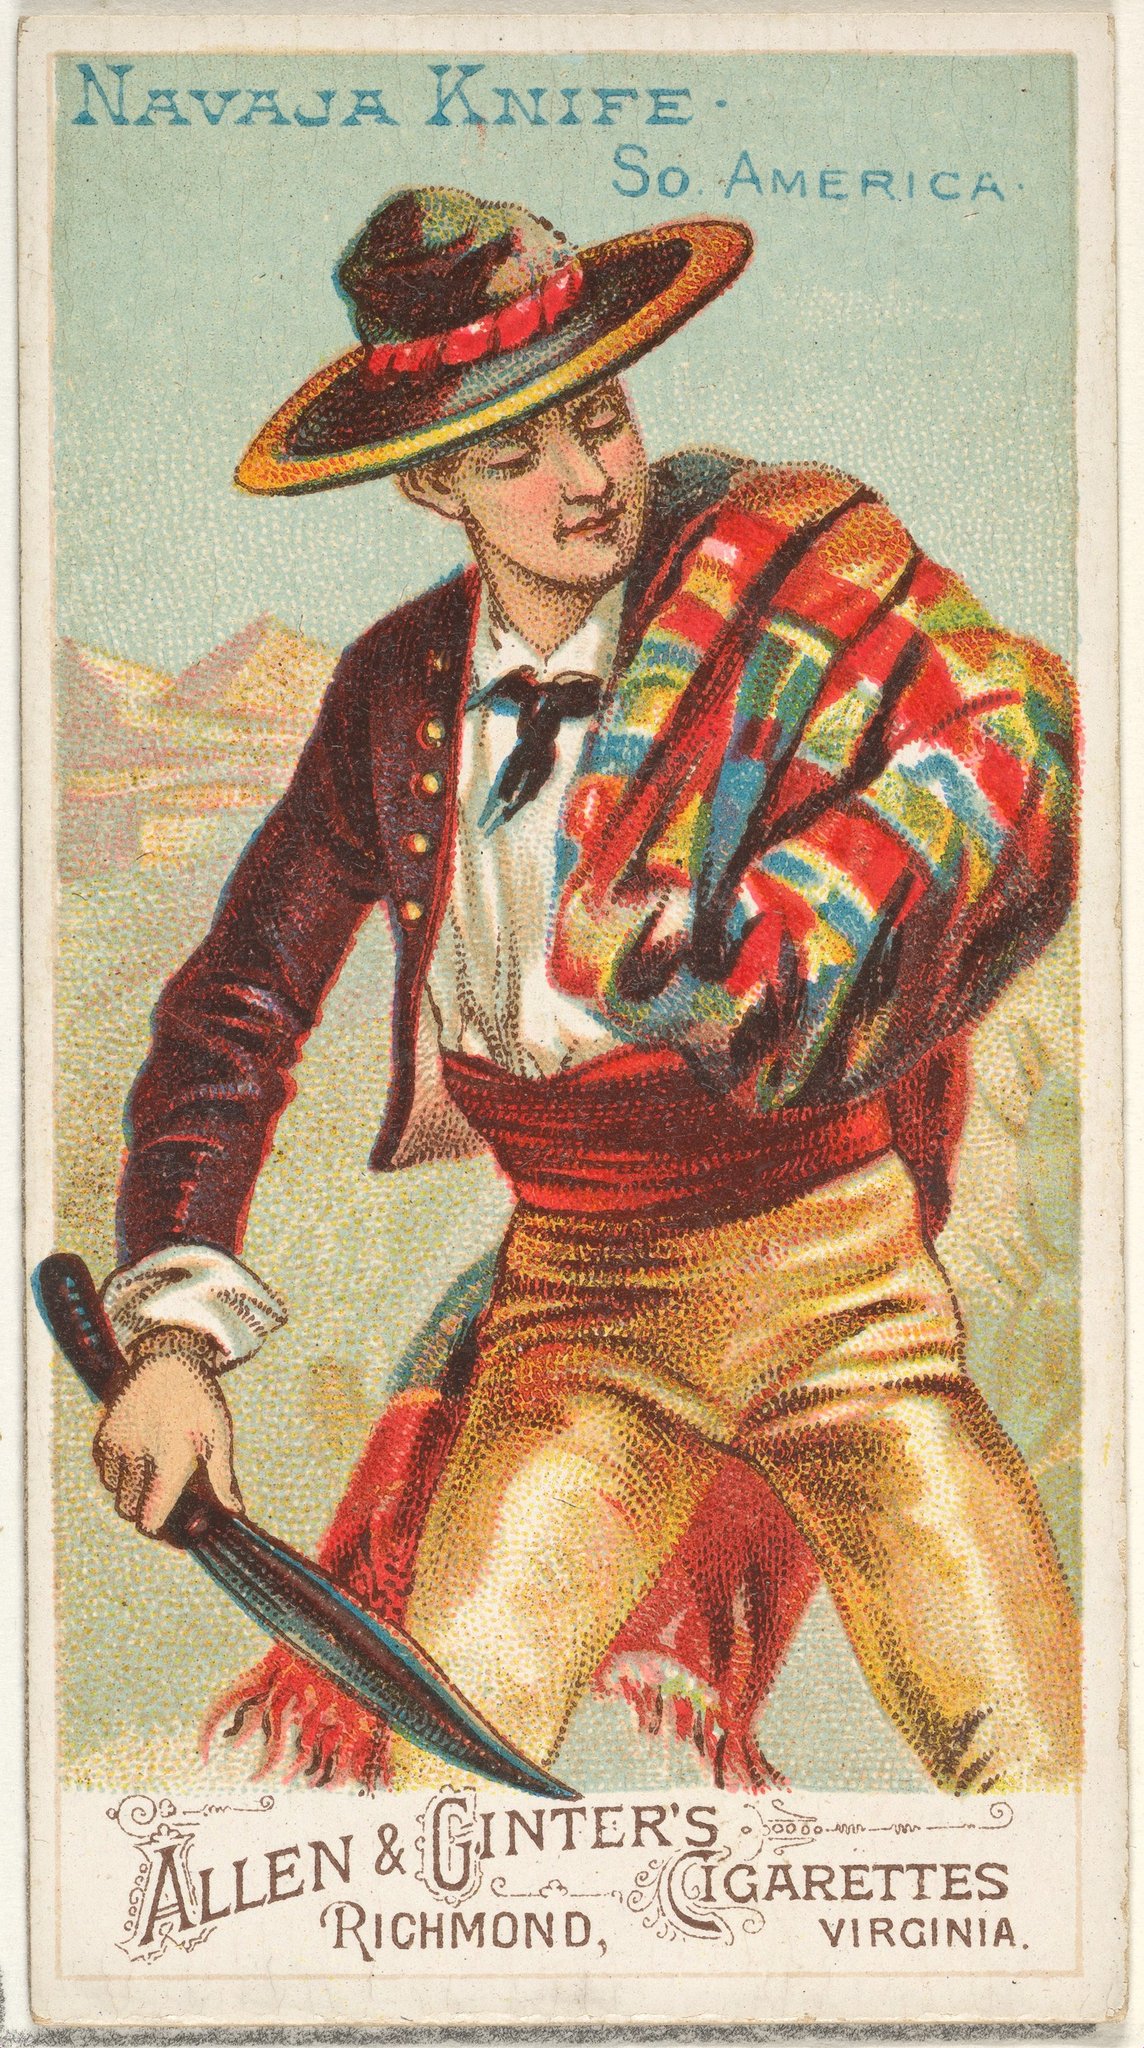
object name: print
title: Navaja Knife, South America, from the Arms of All Nations series (N3) for Allen & Ginter Cigarettes Brands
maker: allen & ginter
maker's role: publisher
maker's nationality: american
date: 1887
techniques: color lithograph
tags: knives,men